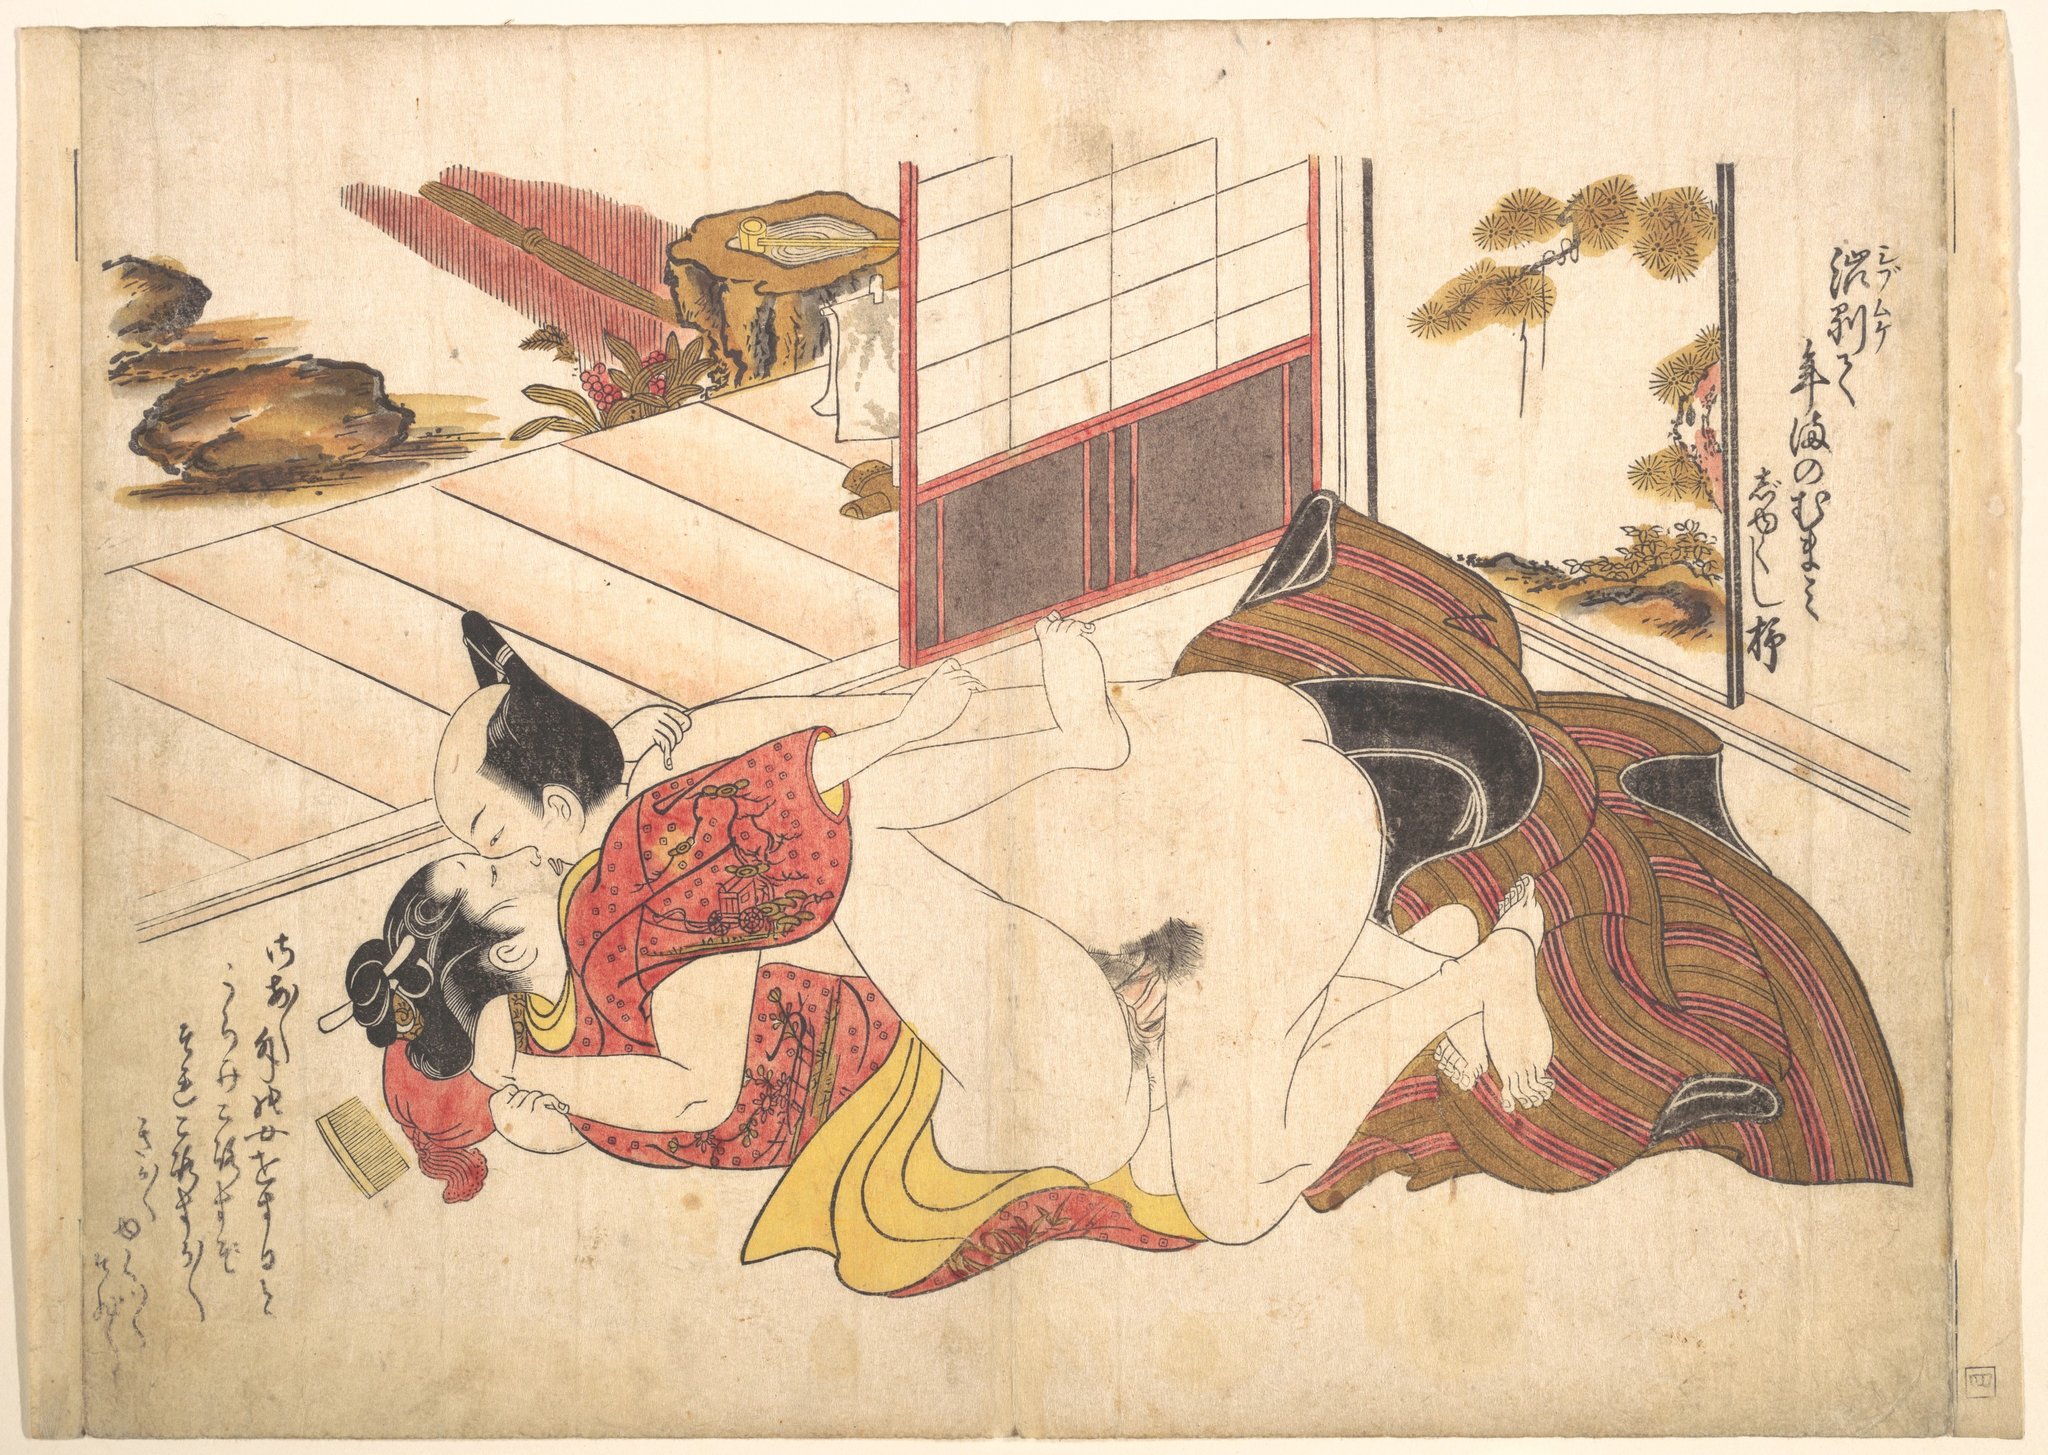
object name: print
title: Bedroom Scene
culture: japanese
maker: okumura masanobu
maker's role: artist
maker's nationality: japanese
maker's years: 1686-1764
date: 1739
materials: ink, paper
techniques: hand coloring, woodblock print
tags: bedrooms,male nudes,female nudes